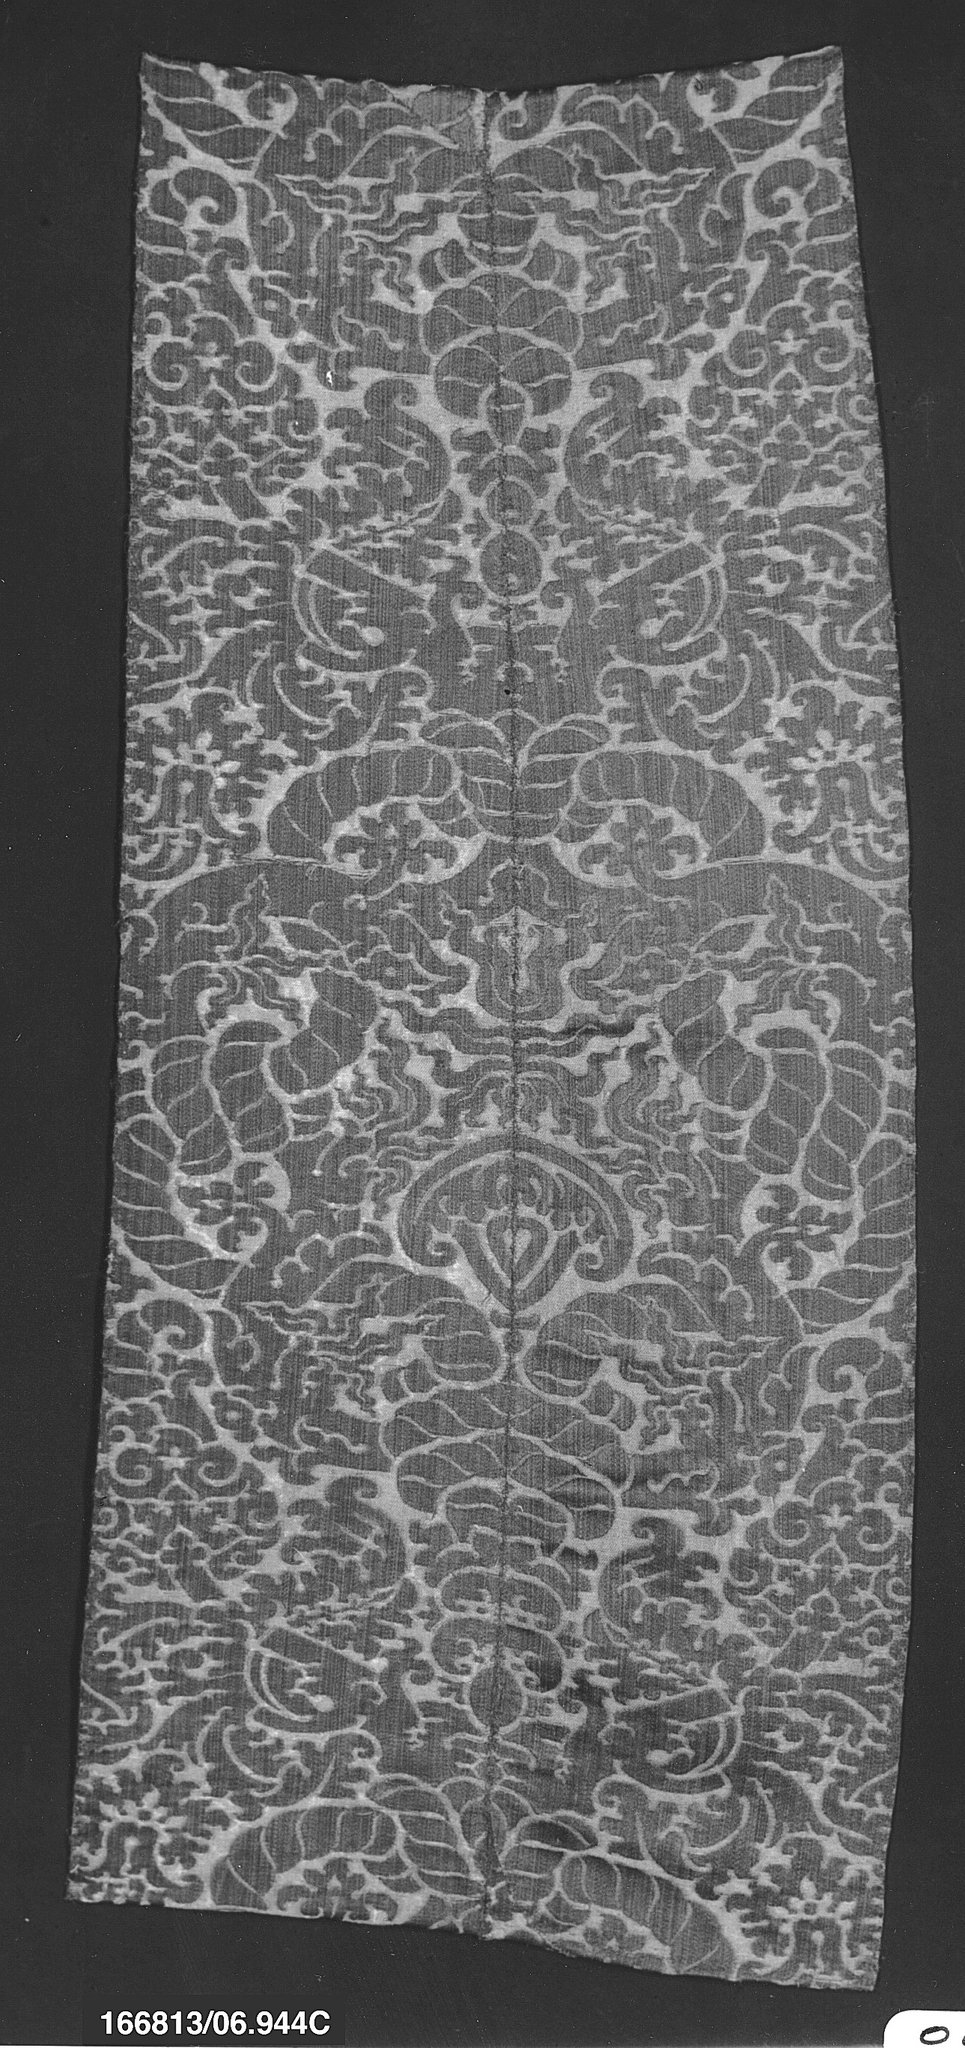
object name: piece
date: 1601-1700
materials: metal thread, silk